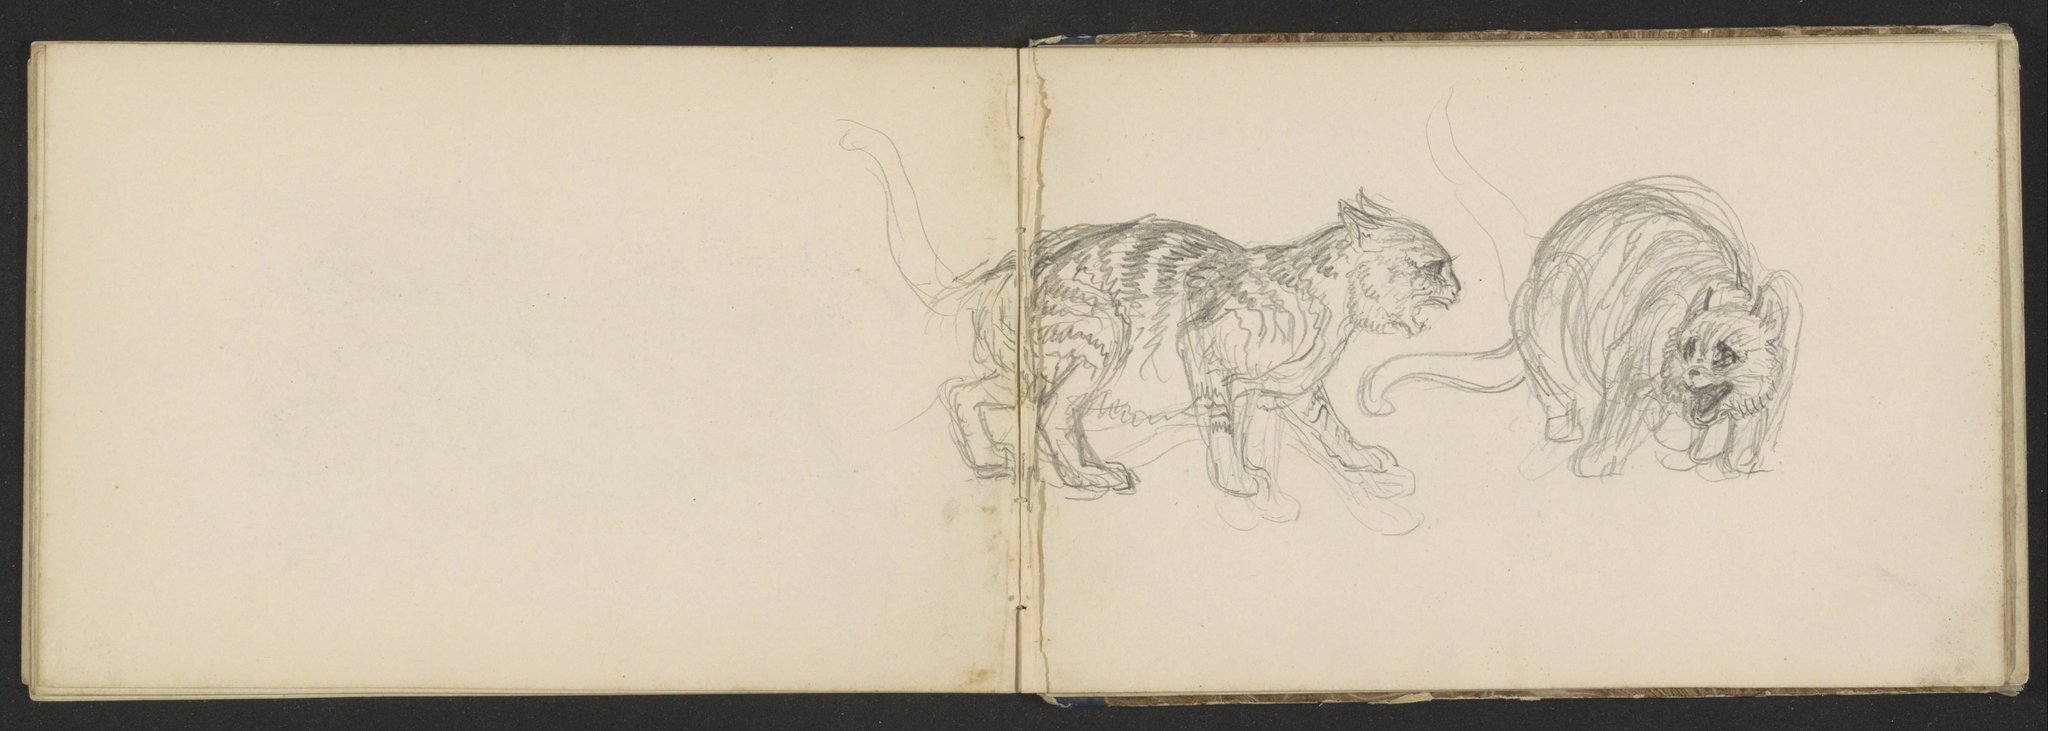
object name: sketchbook leaf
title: Twee naar elkaar blazende katten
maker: Anonymous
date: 1841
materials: paper, pencil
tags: cat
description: Blad 16 verso en 17 recto uit een schetsboek met 33 bladen.